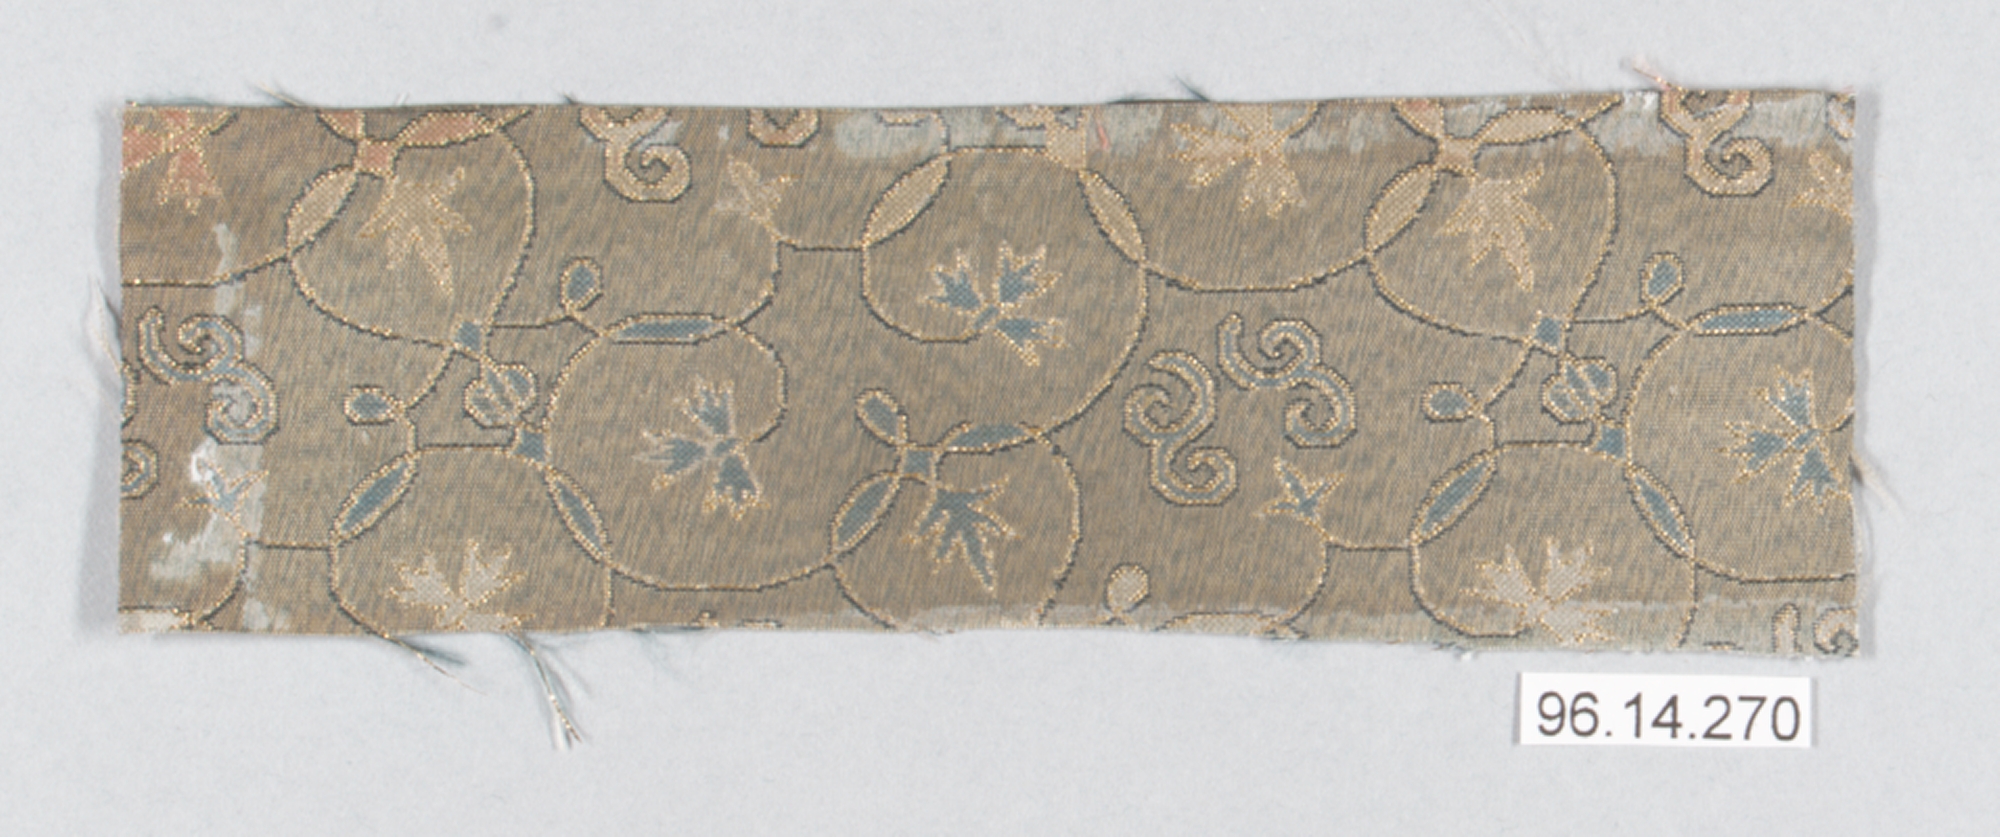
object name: piece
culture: japanese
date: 1701-1900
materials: silk